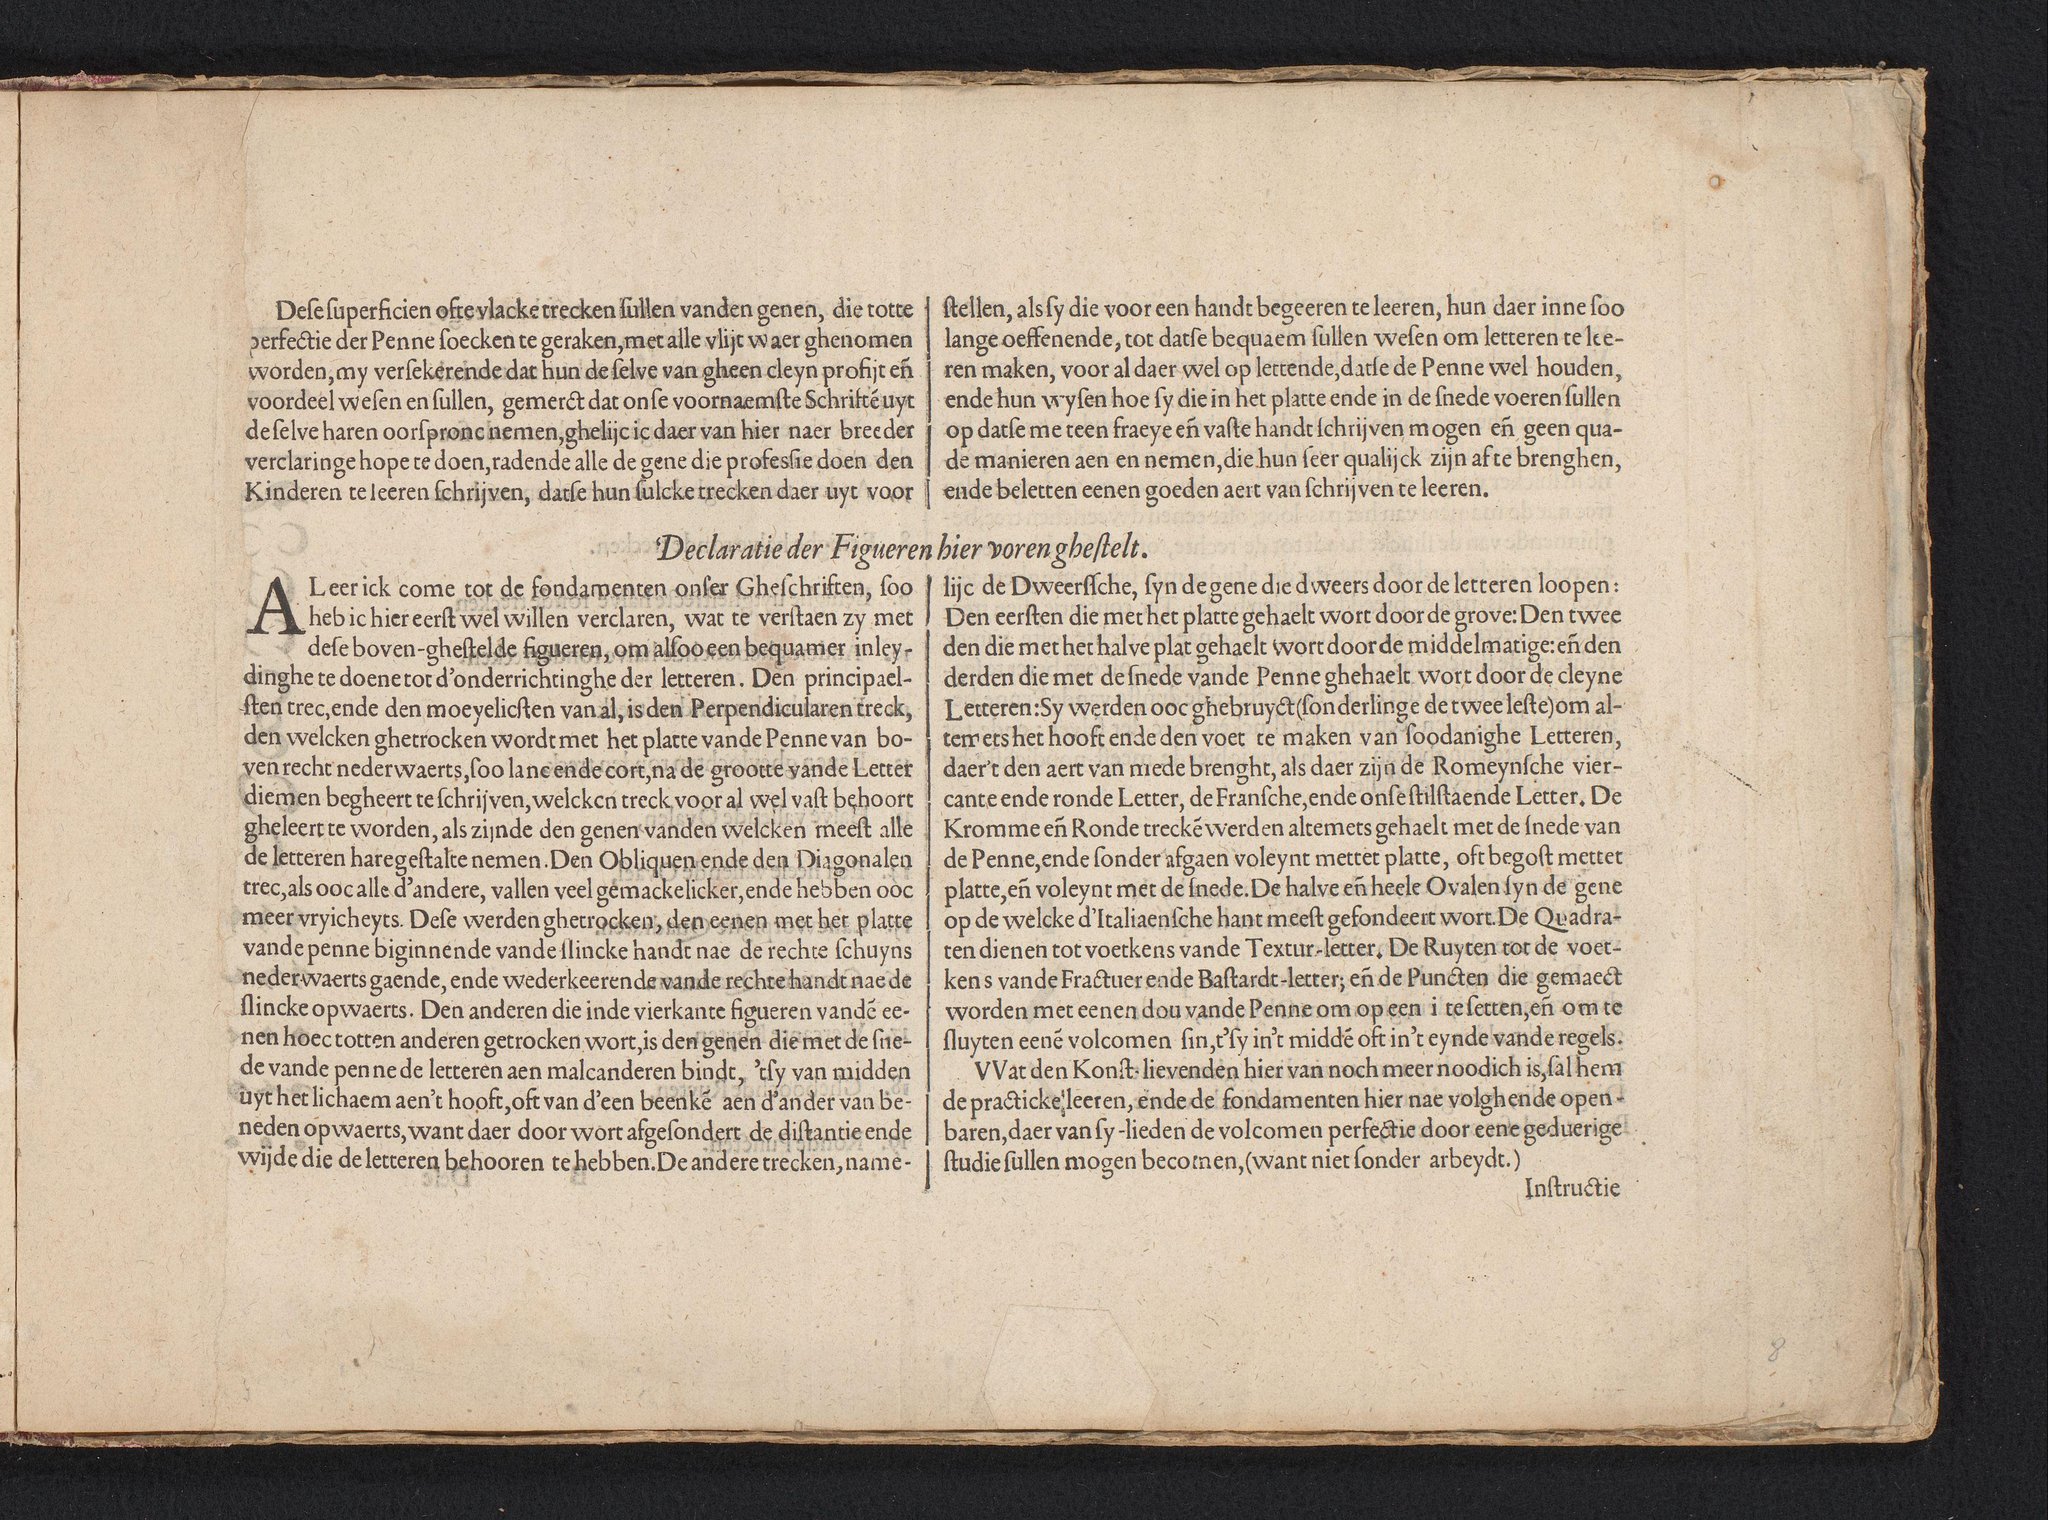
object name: text sheet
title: Spieghel der schrijfkonste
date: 1608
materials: paper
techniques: letterpress printing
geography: amsterdam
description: Folio B1v. Instructie hoe de rietpen vastgehouden moet worden (tweede vervolg) met een uitleg van de voorbeelden op de vorige pagina. De tekst vangt aan met een kleine initiaal A. Het tekstblad maakt deel uit van een album.